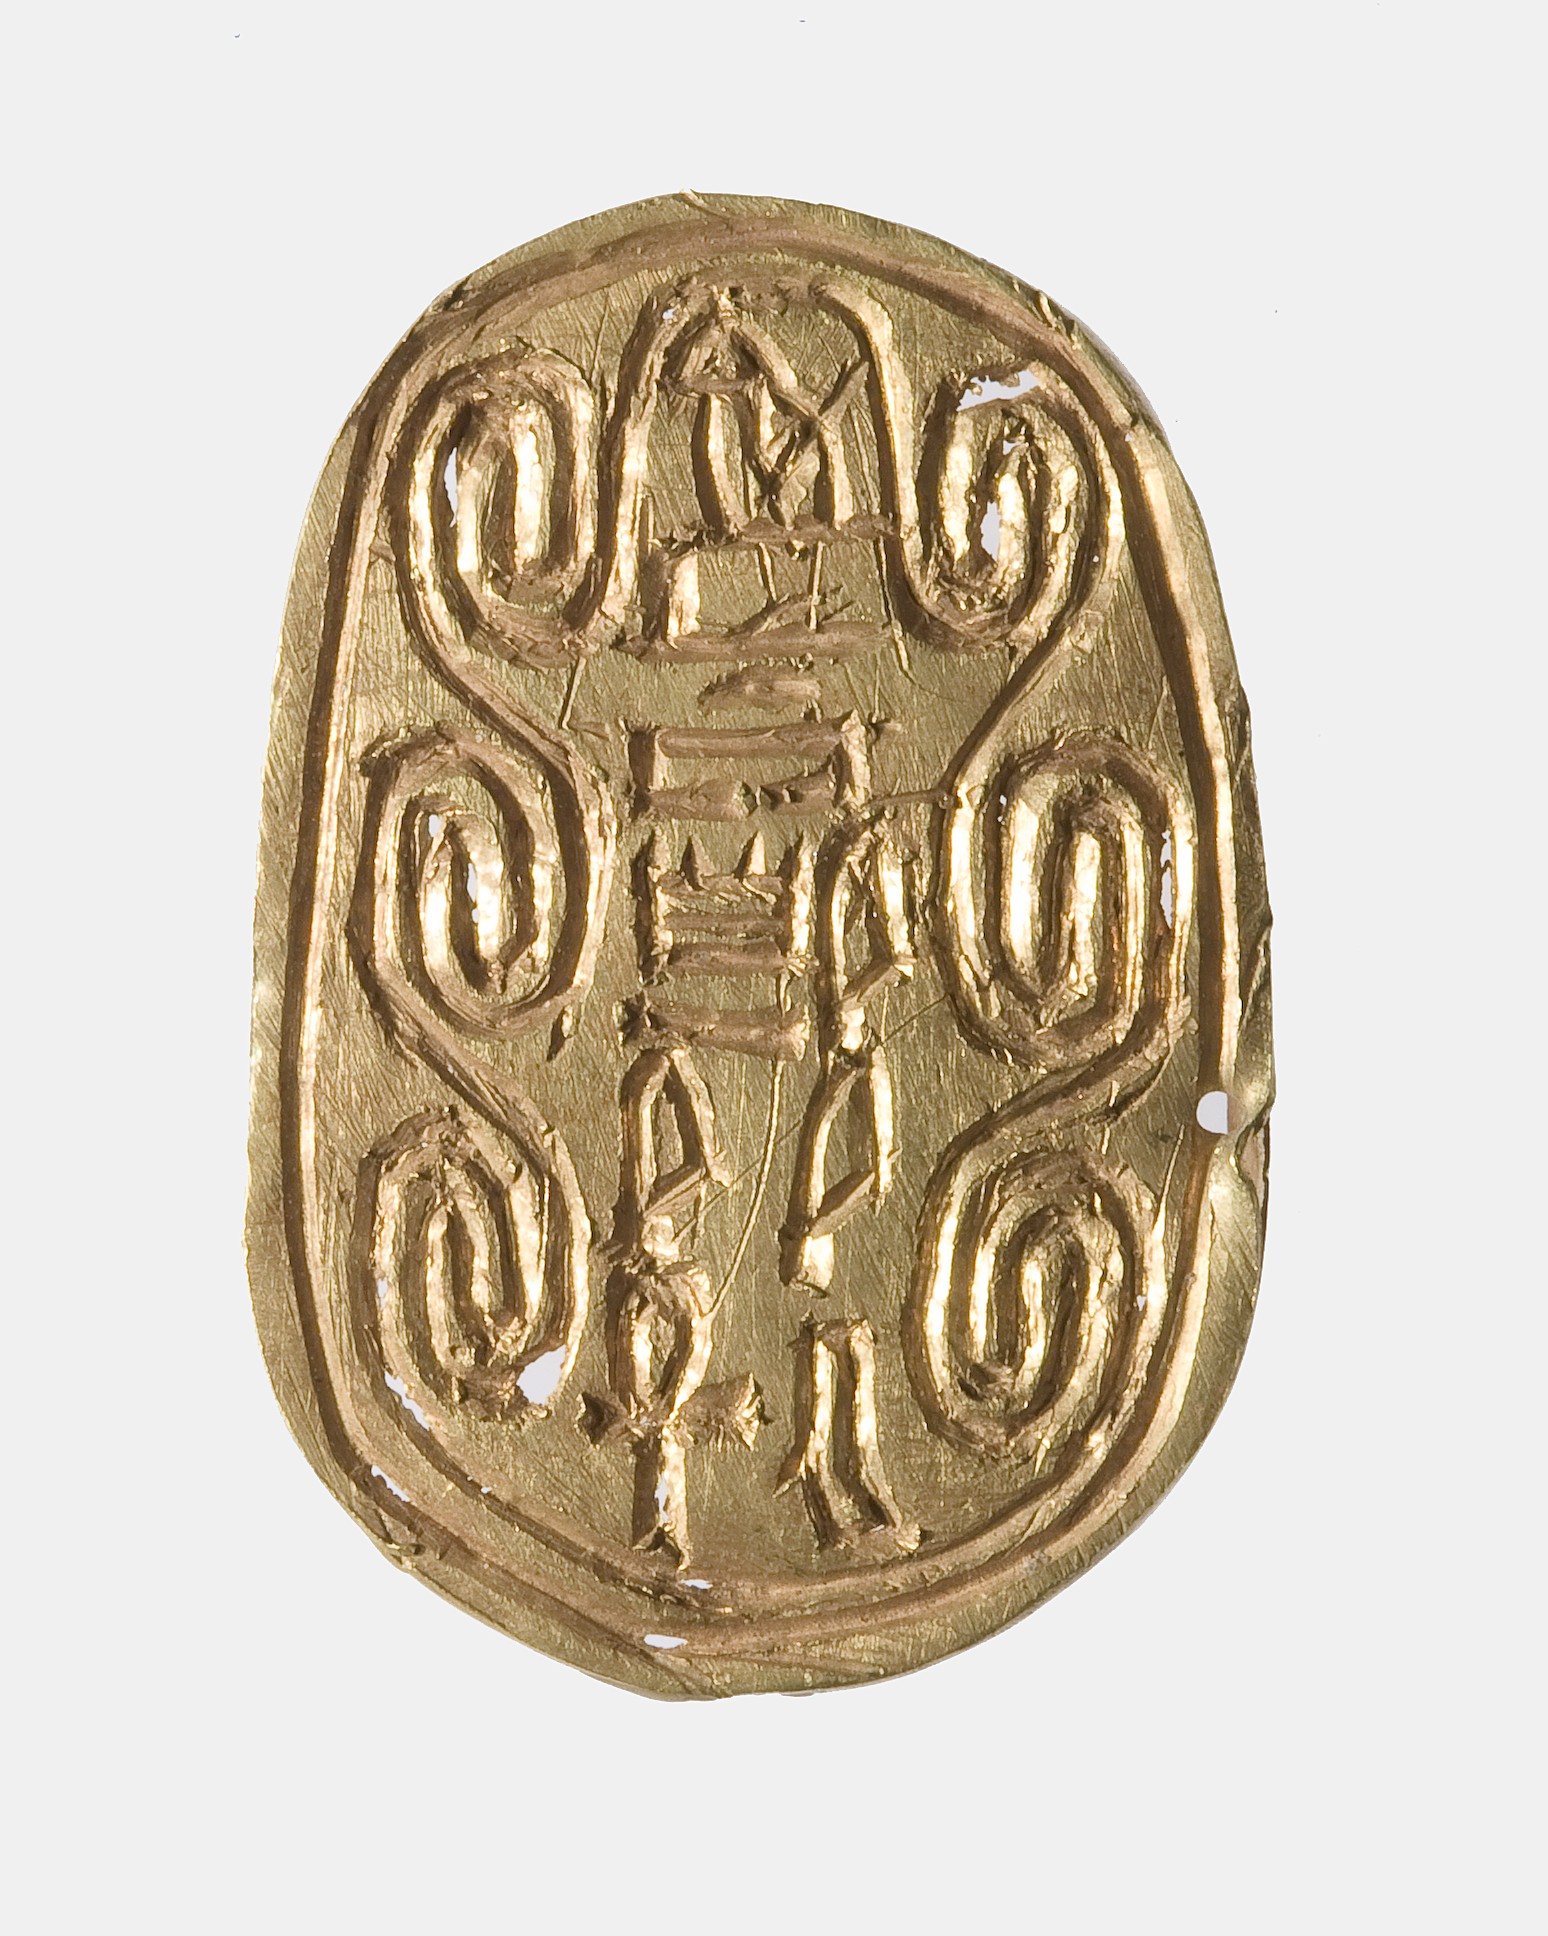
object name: scarab cap no longer on ring, base plate cover, scroll, official private name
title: Gold Base Plate of a Scarab of an Official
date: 1802-1640 BCE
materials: gold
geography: egypt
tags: hieroglyphs,scarabs